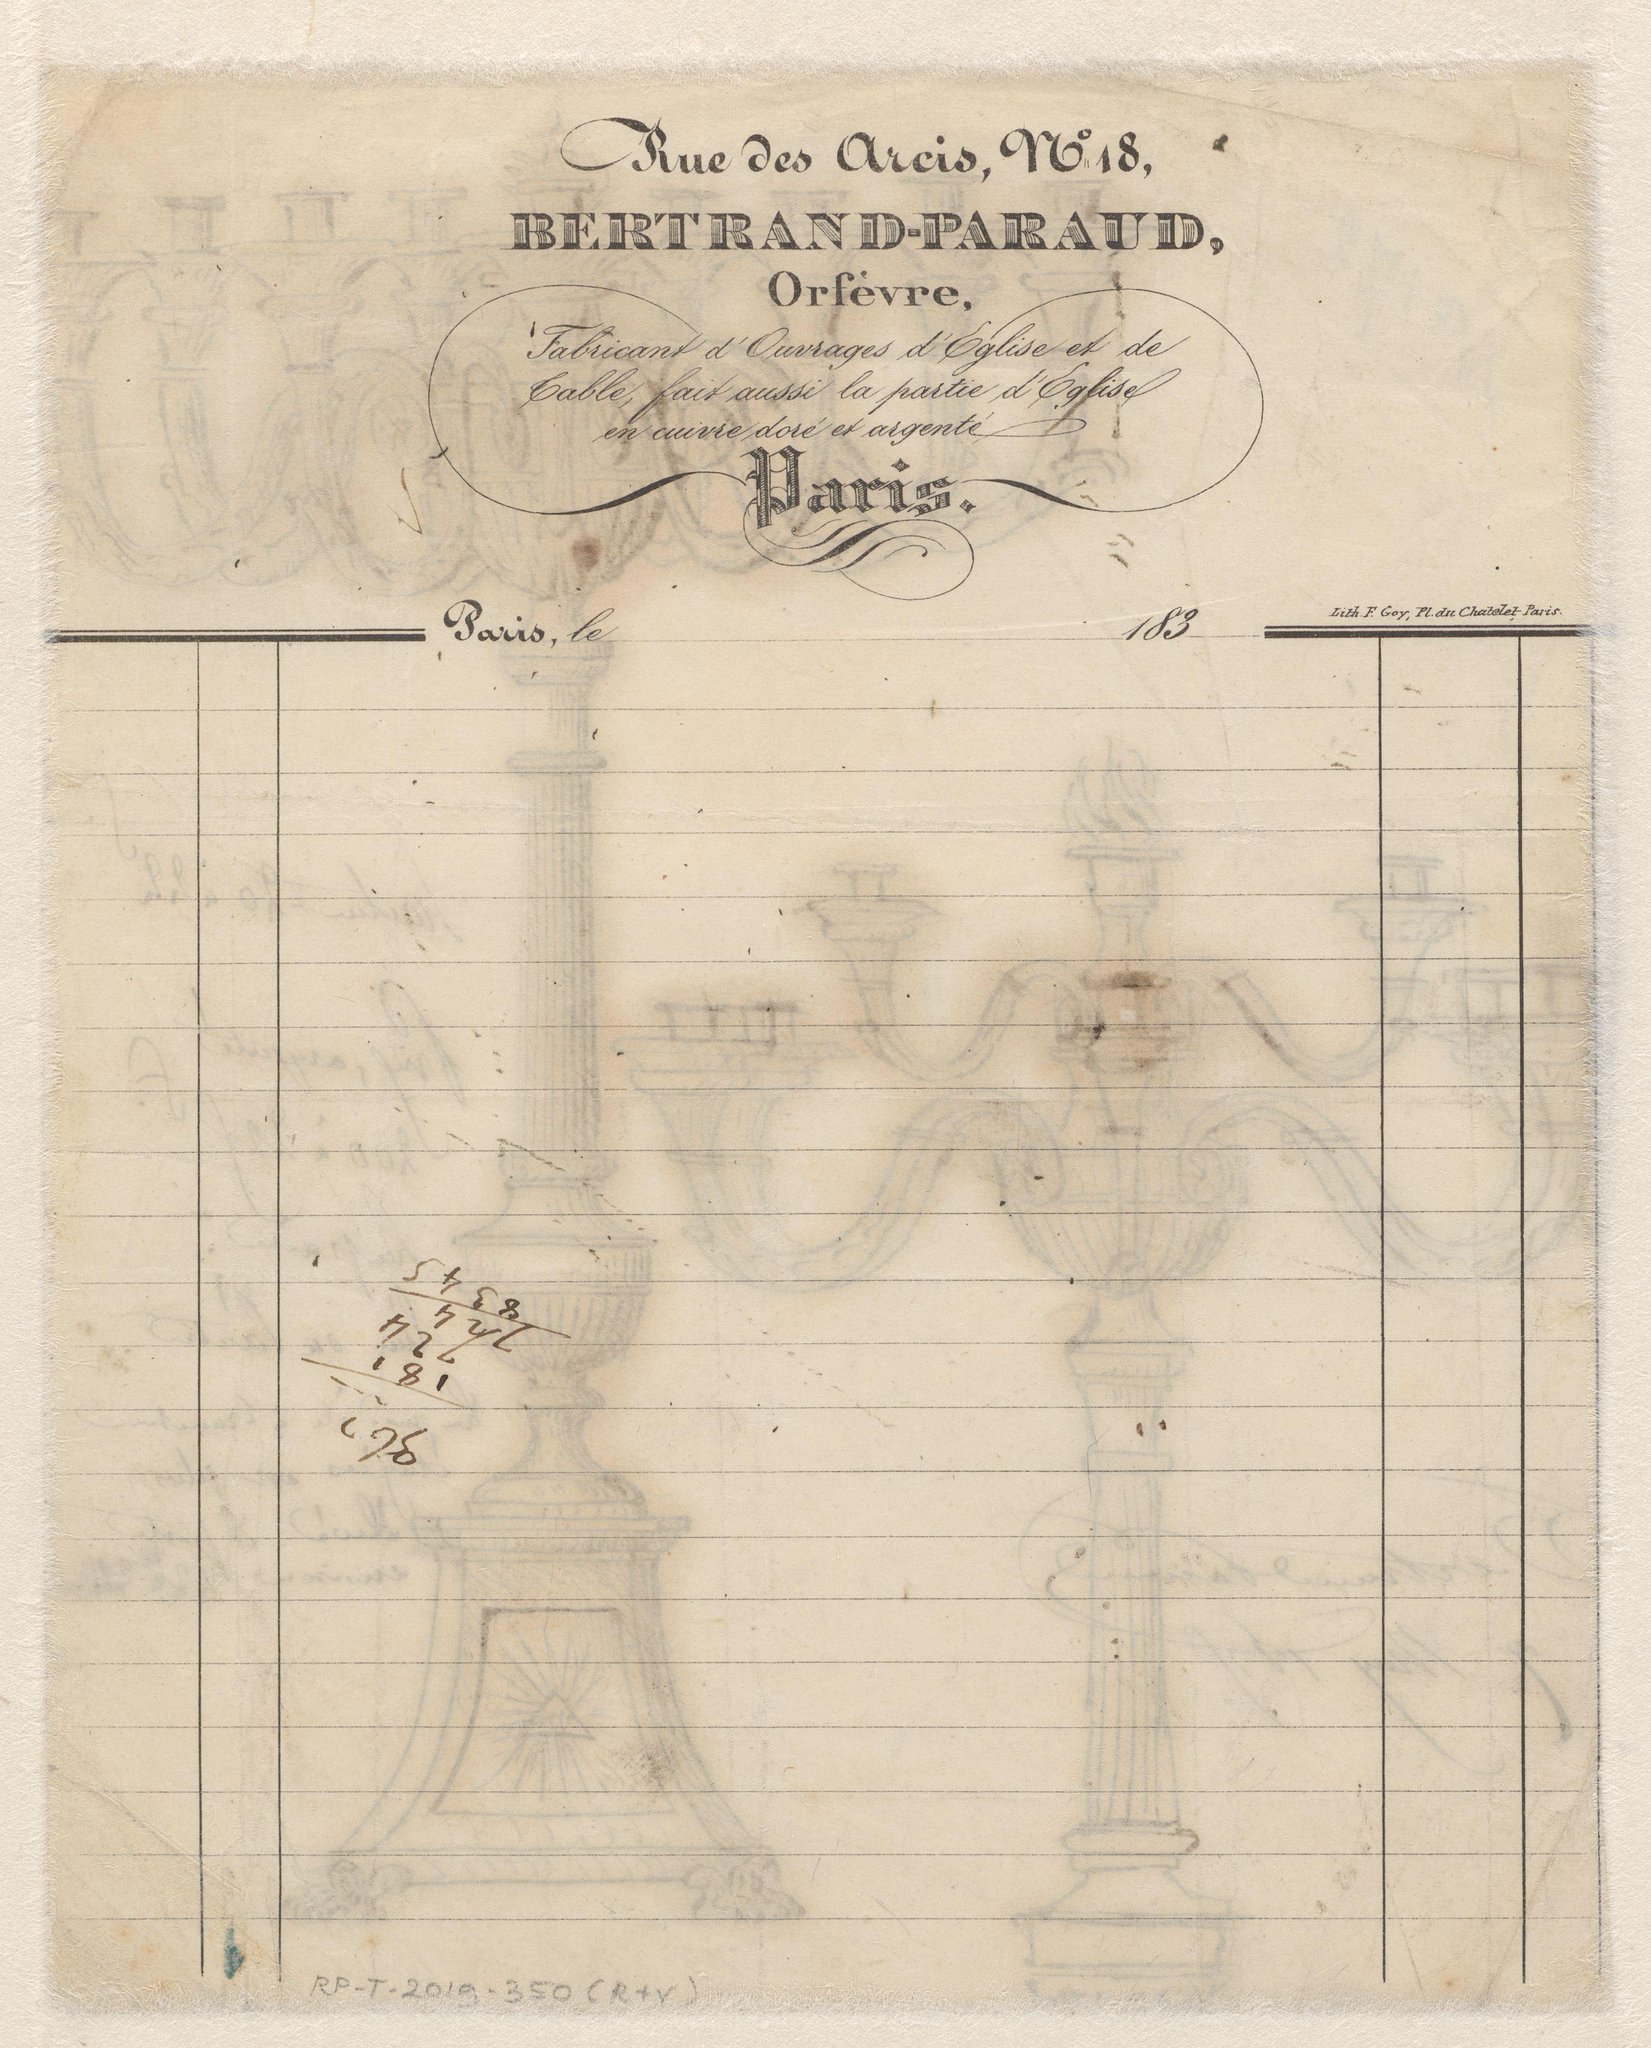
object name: design drawing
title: Twee ontwerpen voor kandelabers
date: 1835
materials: graphite, ink, paper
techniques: pen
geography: france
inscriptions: signature: ‘Lith. F. Goy, Pl. du Chatelet’, inscription: ‘Berekening in pen en bruine inkt.’, inscription: ‘Rue des Arcis, No. 18, BERTRAND-PARAUD, Orfèvre, / Fabrikant d’Ouvrages d’Eglise et de / Table, fait aussi la partie d’Eglise / en cuivre doré et argenté / Paris. / Paris, le 183’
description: Verso: gegraveerd factuurpapier van Bertrand-Paraud, met opschrift.